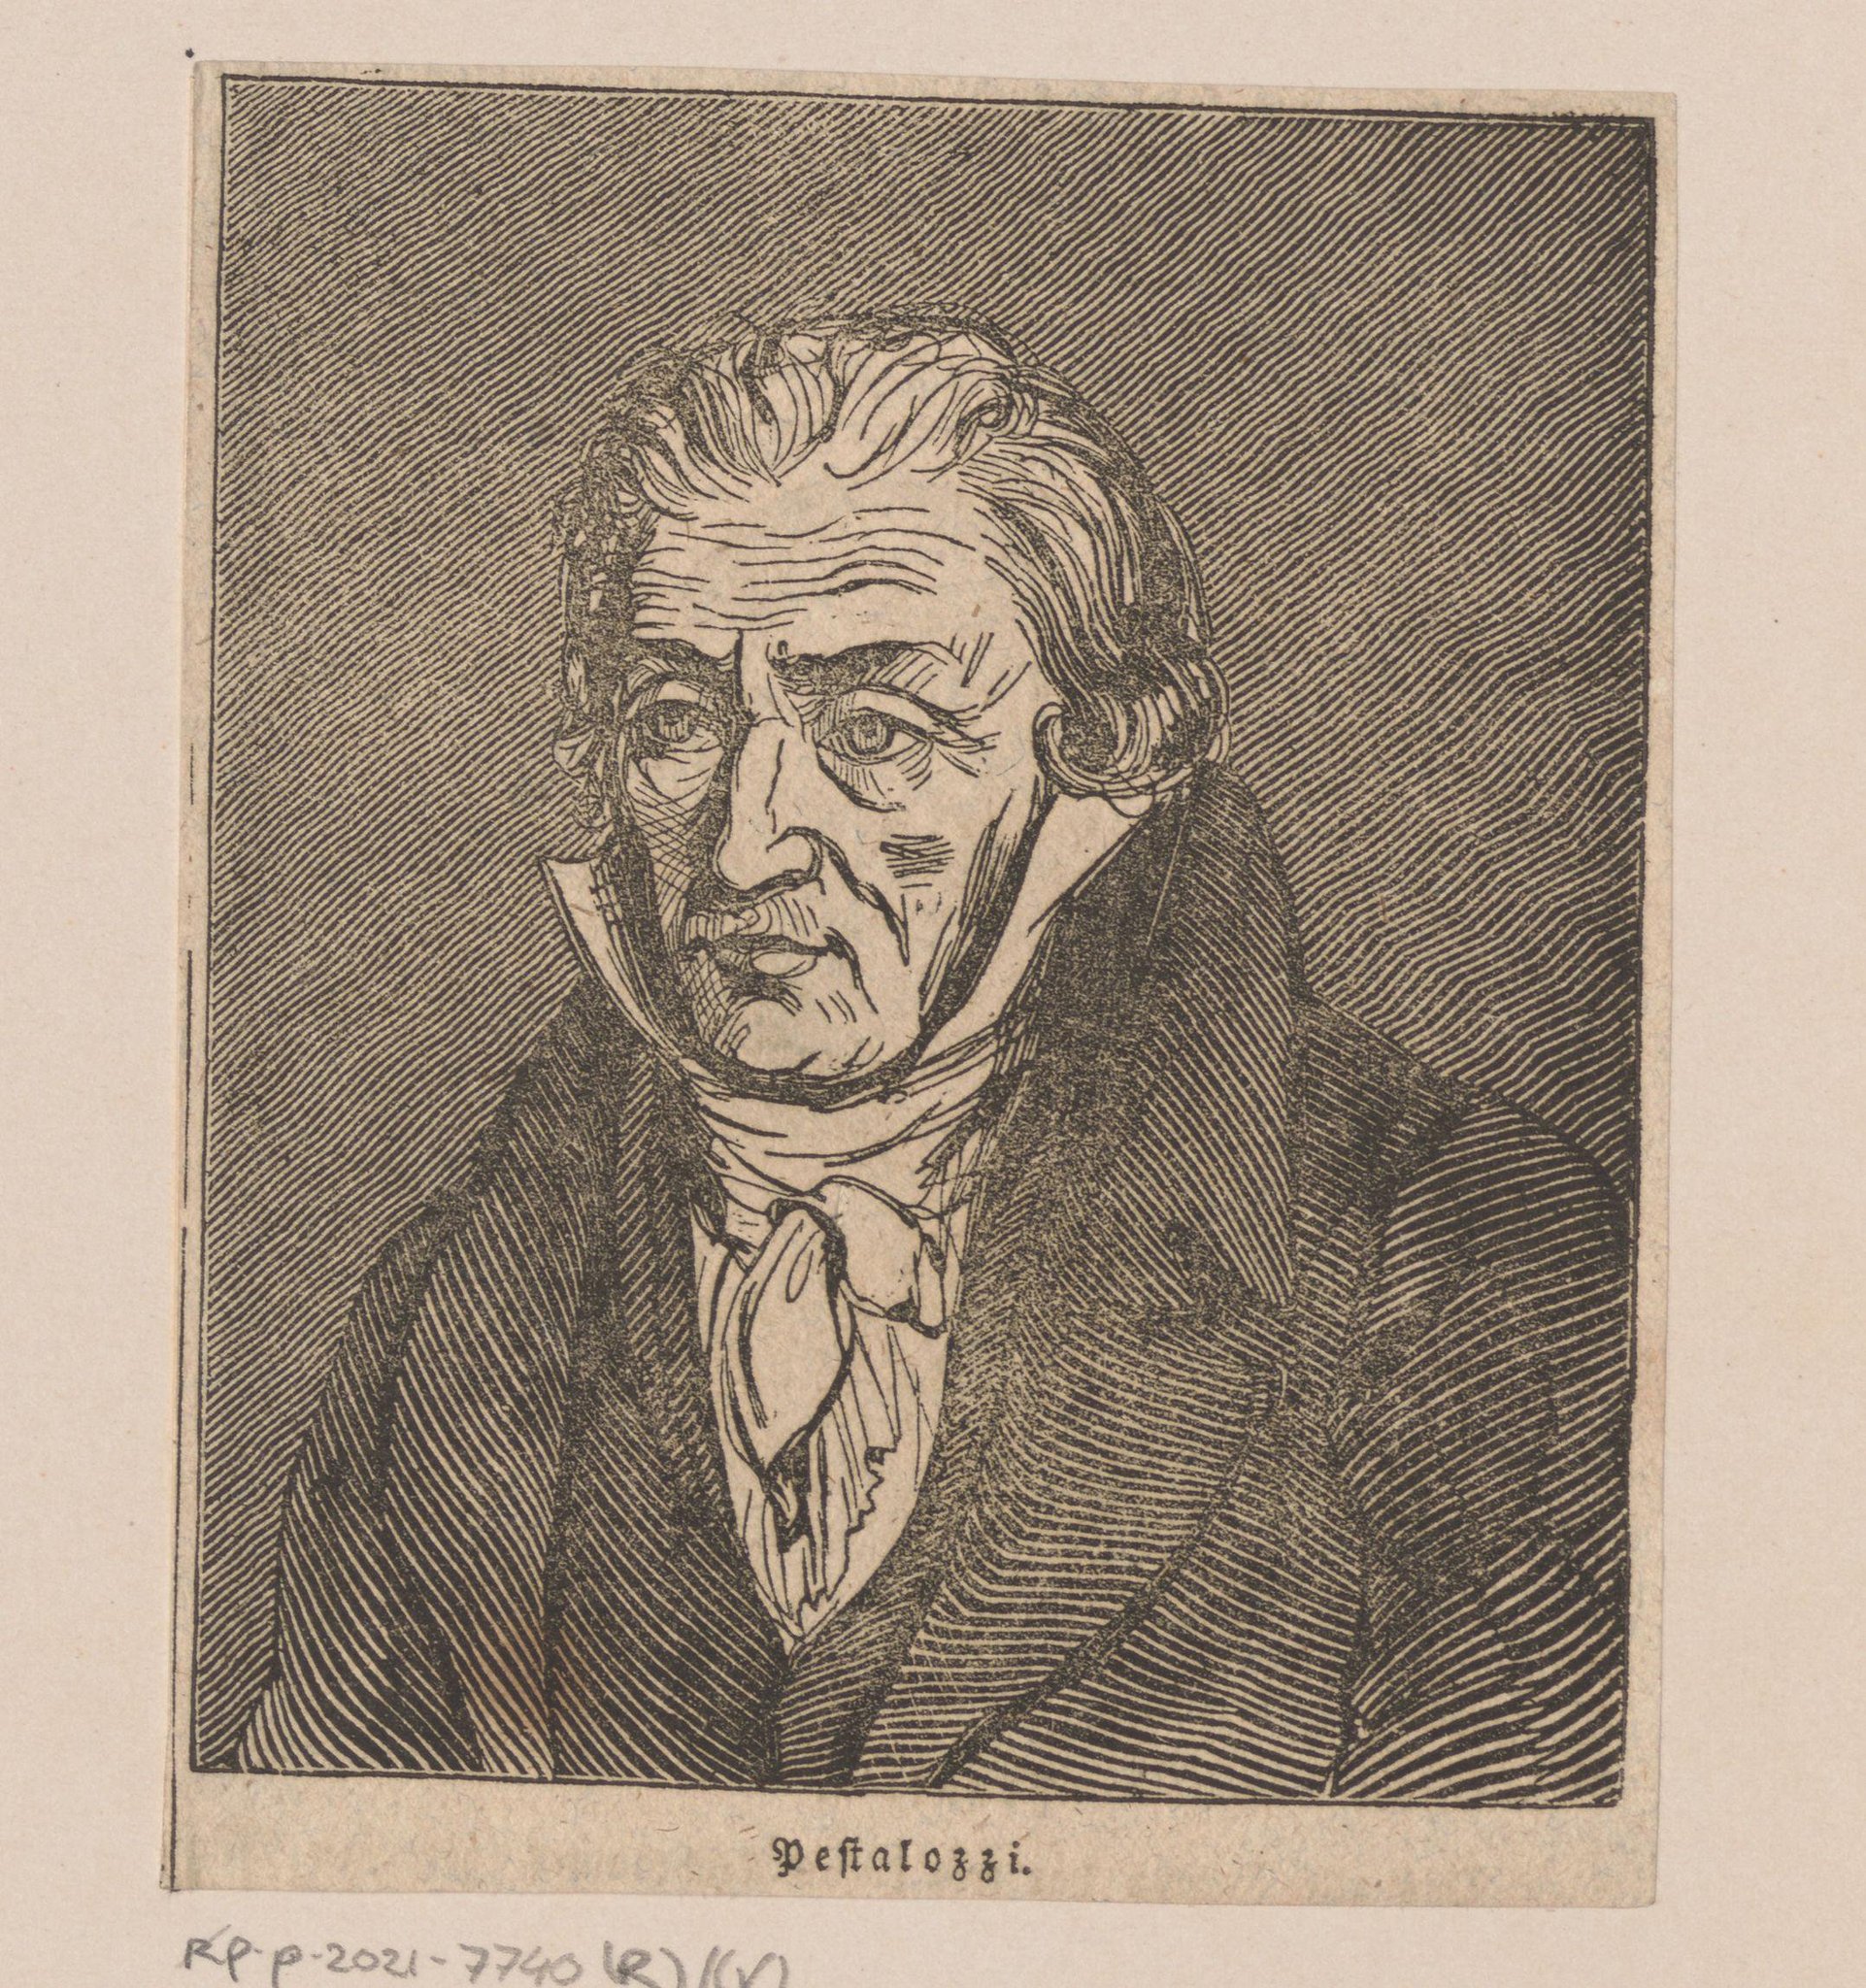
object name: book illustration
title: Portret van Johann Heinrich Pestalozzi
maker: Anonymous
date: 1800-1849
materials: paper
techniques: letterpress printing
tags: adult man, historical persons